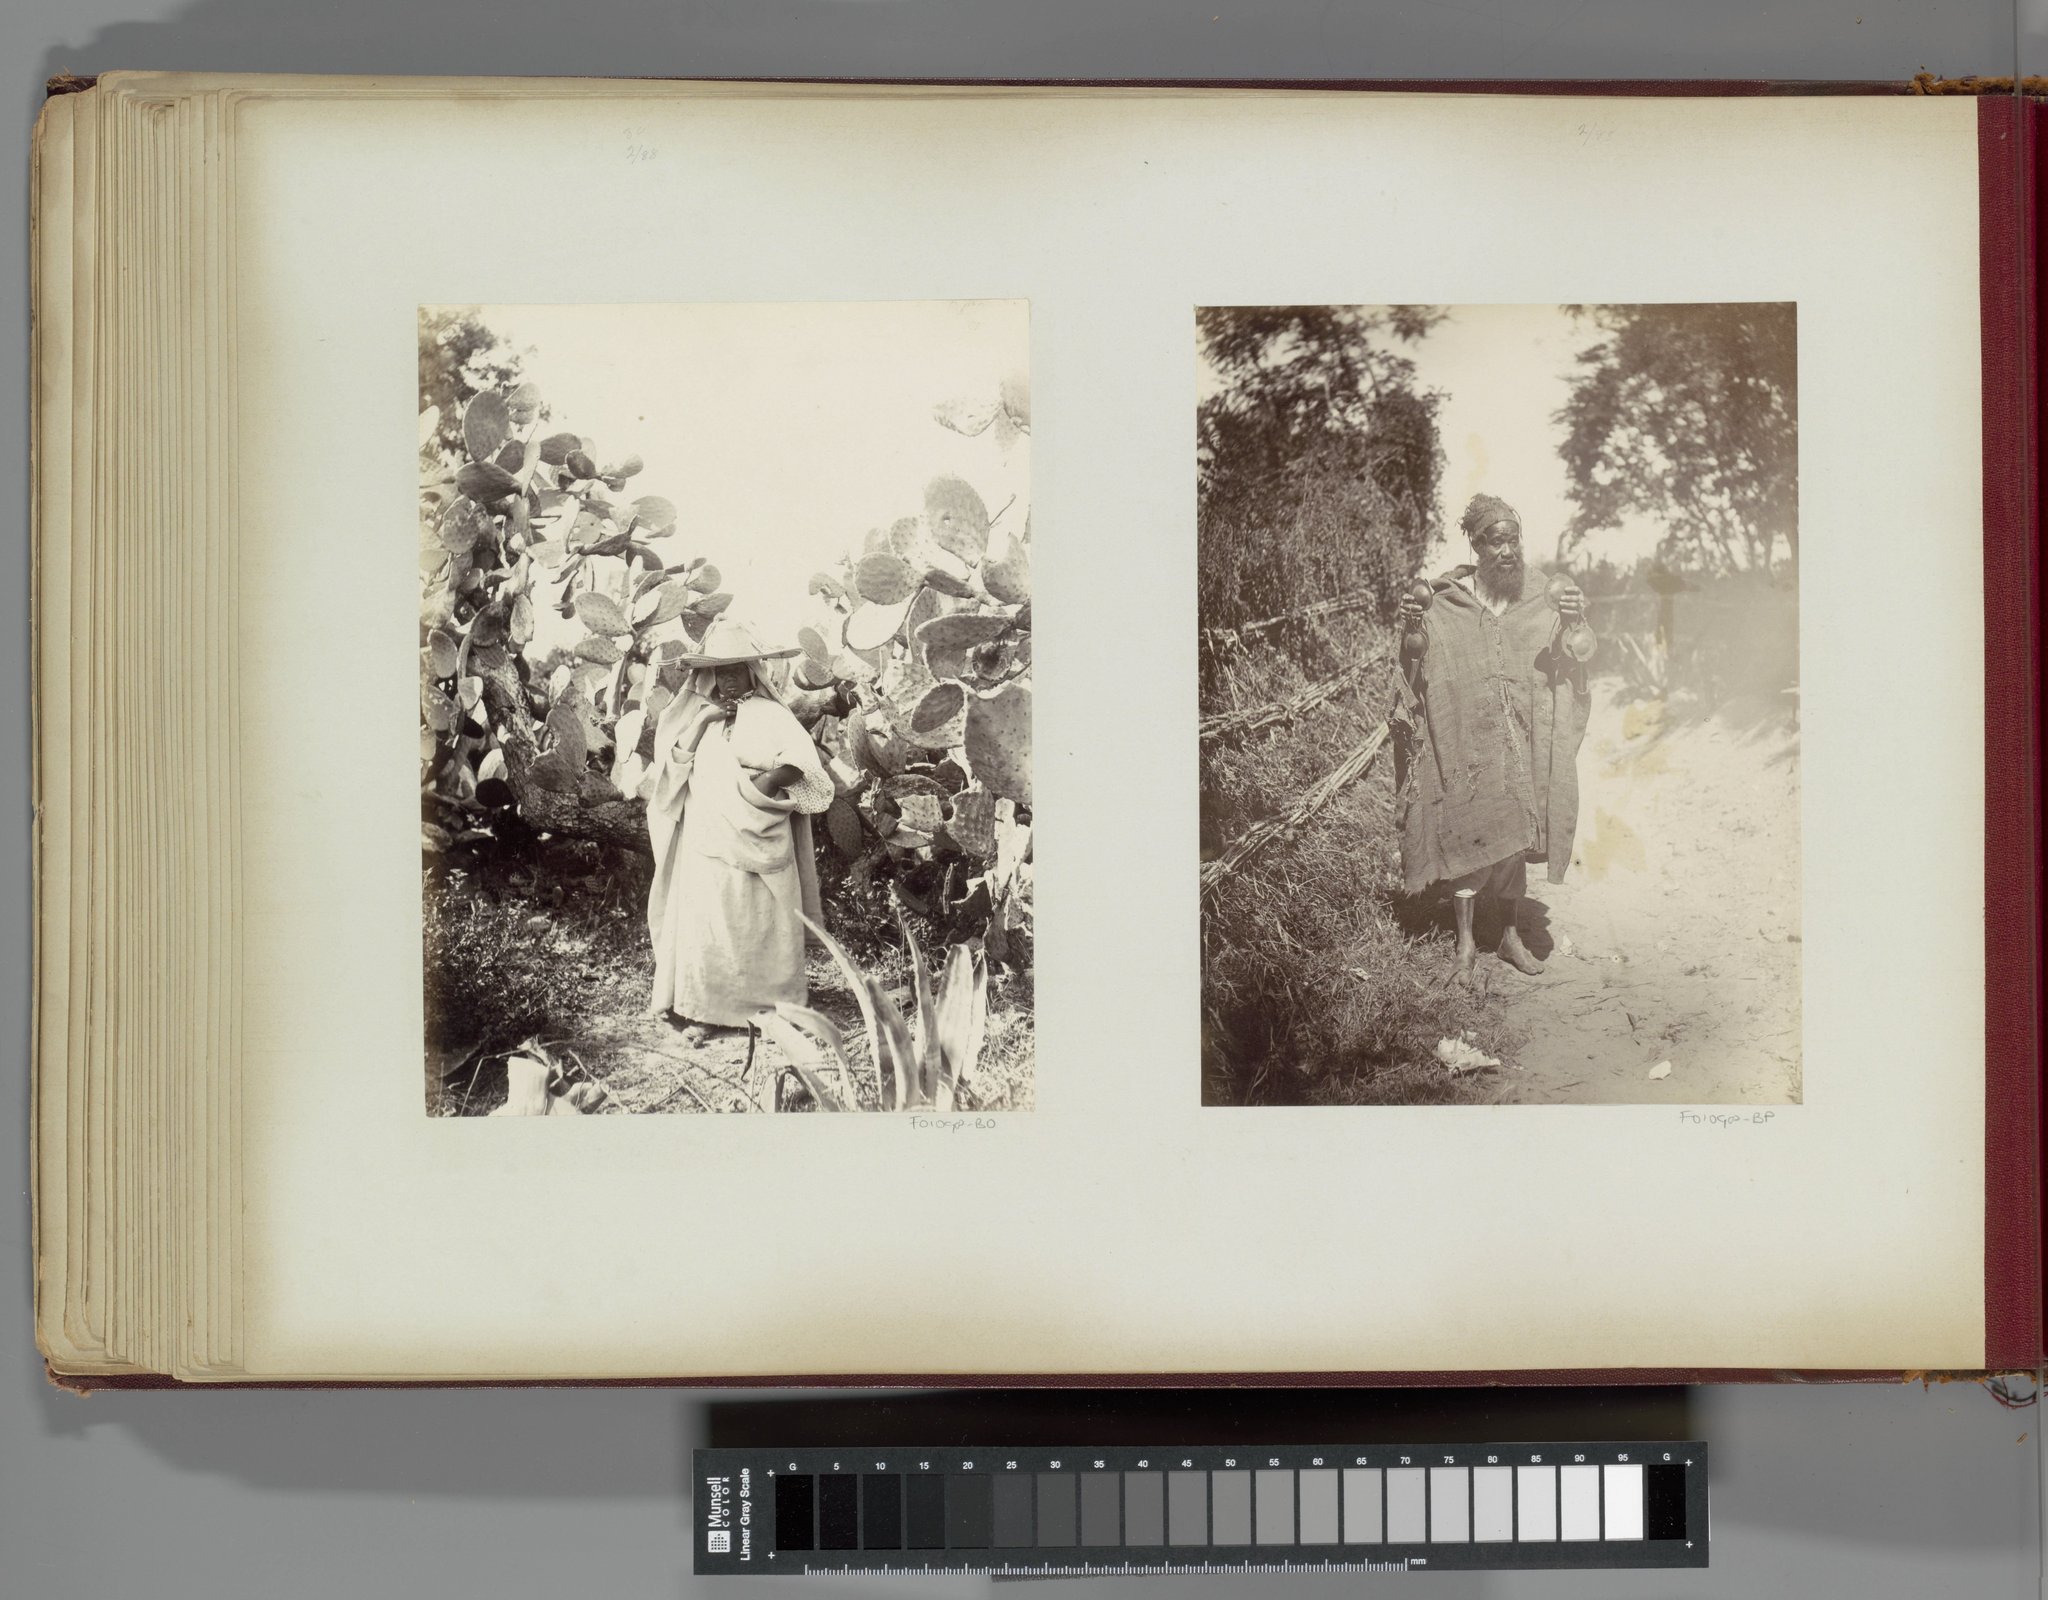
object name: photograph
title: Portret van een vrouw in een omslagmantel met breedgerande hoed staande tussen cactussen in Marokko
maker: Anonymous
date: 1860-1880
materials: cardboard, paper, photographic support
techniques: albumen print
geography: morocco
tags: head-gear: hat, plants and herbs: cactus, coat, cape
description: Onderdeel van Reisalbum met foto's van bezienswaardigheden in Spanje en Marokko.